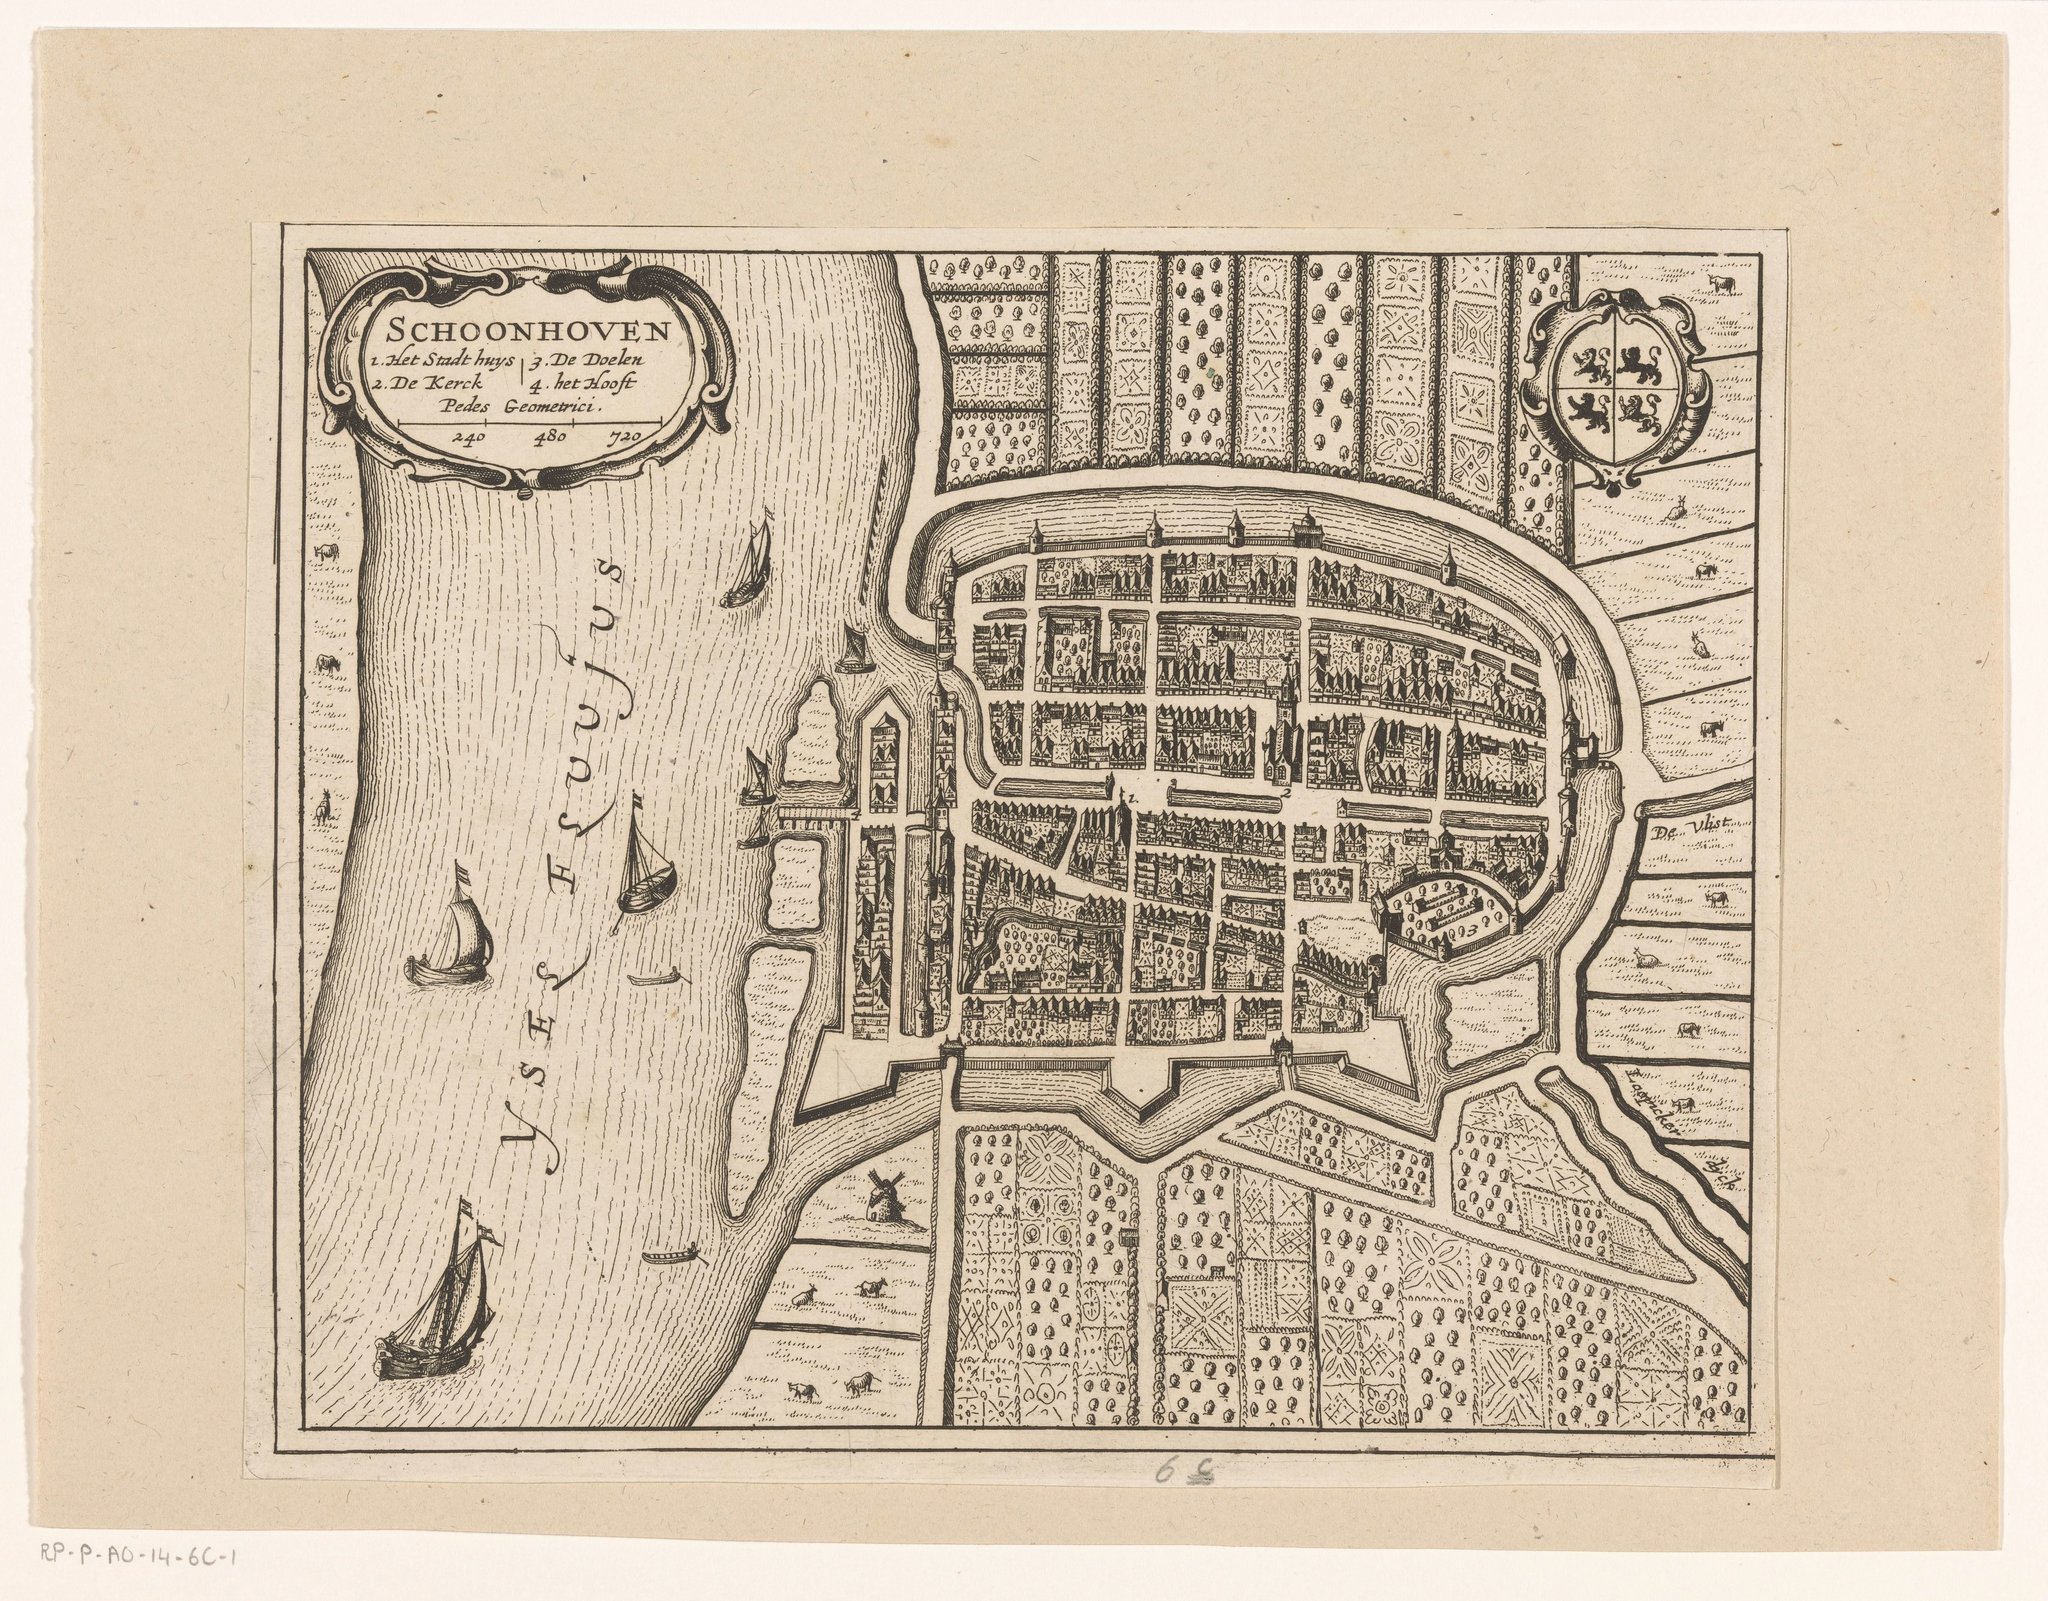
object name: area plan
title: Schoonhoven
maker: Anonymous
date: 1657-1704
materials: paper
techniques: engraving, etching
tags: coat of arms (as symbol of the state, etc.) (+ city; municipal), maps of cities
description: Deze plattegrond werd samen met drie andere plattegronden (van Woerden, Oudewater en Delfshaven) gedrukt van één koperplaat. Deze prent is verschenen in 'Theatrum Urbium Celebriorum totius Belgii sive Germaniae Inferioris' (Johannes Janssonius, 1657), in 'Tooneel der vermaarste koop-steden en handelsplaatsen van de geheele wereld' (Johannes Janssonius van Waesberge (II), 1682), in 'Teatro Belgico o vero ritratti historici, chronologici, politici e geografici delle Sette Provincie Unite' (Willem de Jonge, 1690) en in 'Theatrum ichnographicum omnium urbium et praecipuorum oppidorum Belgicarum XVII Provinciarum (…)' (Frederik de Wit, ca. 1698-1704). De Wit heeft de plaat vervolgens versneden zodat er vier losse platen ontstonden. Hoewel de drie andere plattegronden zodoende los zijn gedrukt en in atlassen zijn verschenen lijkt het erop dat de plattegrond van Schoonhoven niet los gedrukt is nadat de plaat is versneden.